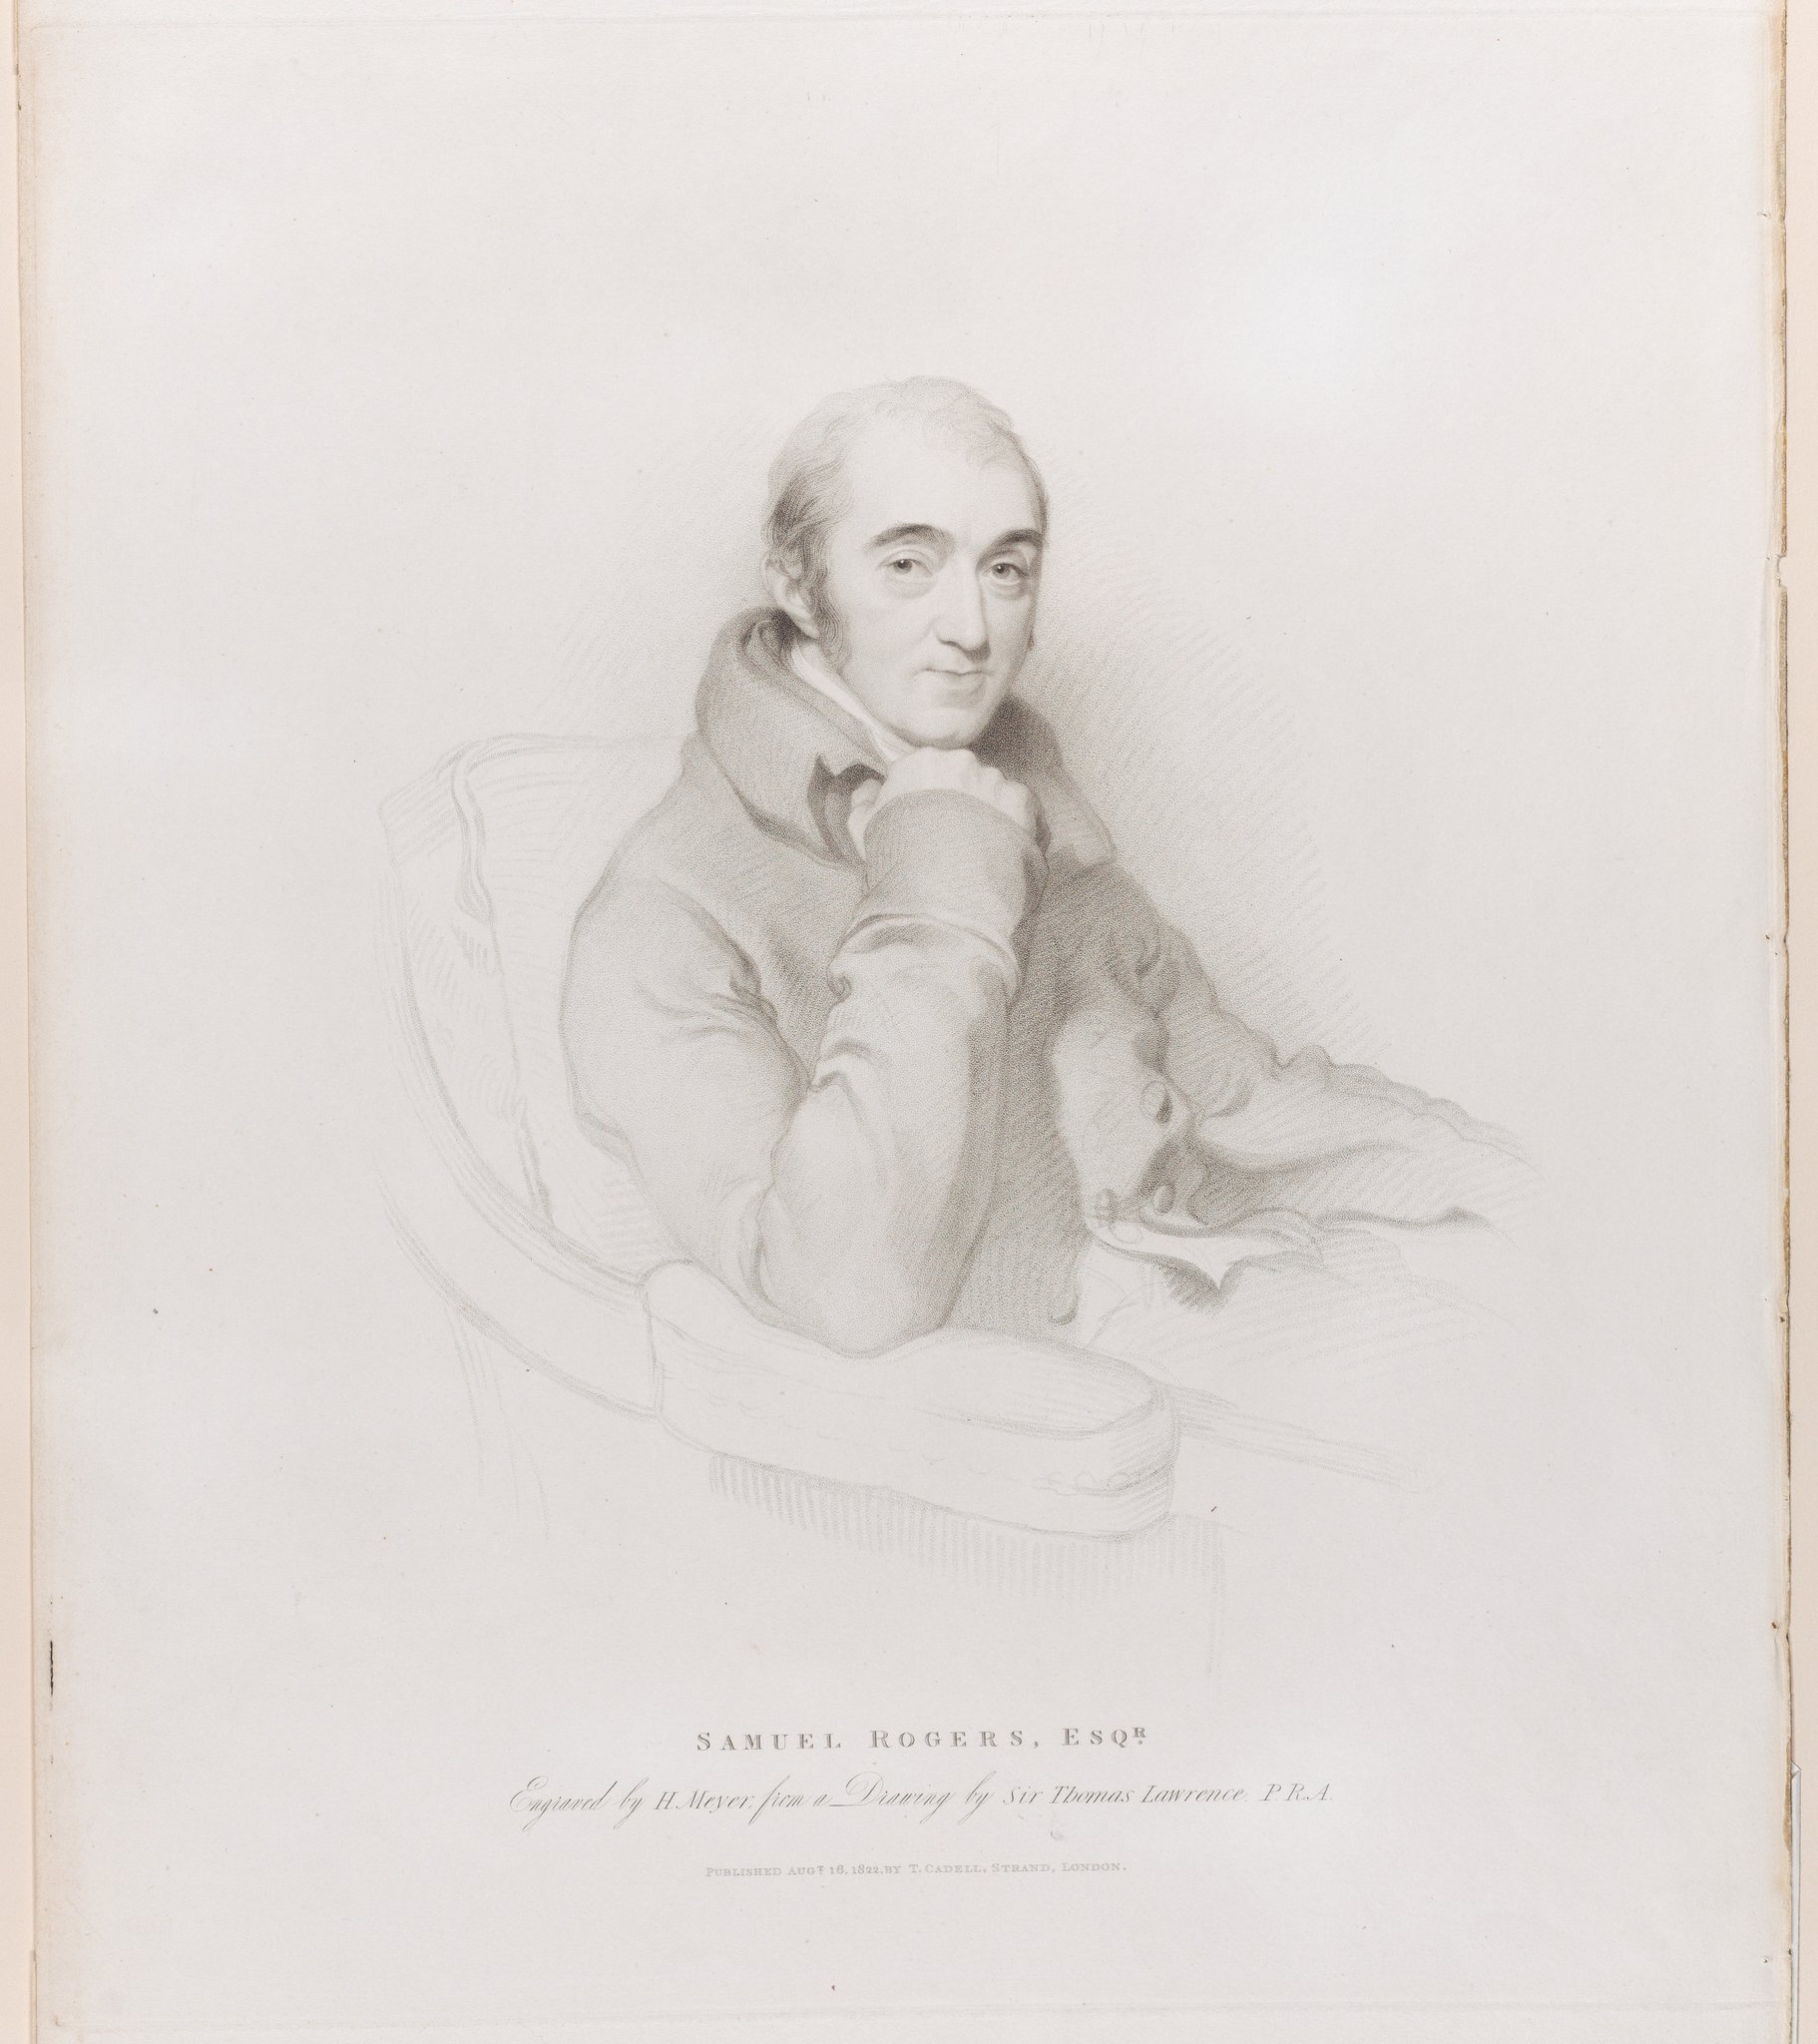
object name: print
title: Samuel Rogers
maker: sir thomas lawrence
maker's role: artist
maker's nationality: british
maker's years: 1769-1830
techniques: engraving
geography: england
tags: men,portraits